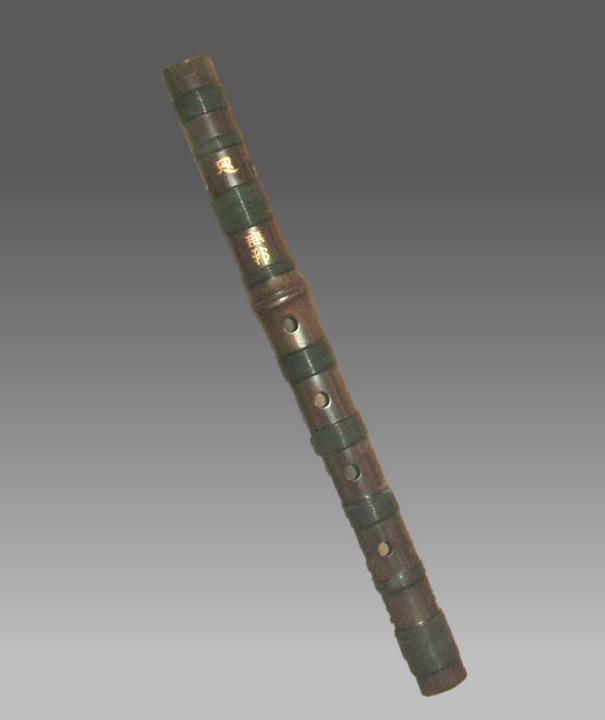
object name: hitoyogiri 一節切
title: Hitoyogiri (一節切)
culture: japanese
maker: attributed to ōmori sōkun 大森宗勲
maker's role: artist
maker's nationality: japanese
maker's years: 1570-1625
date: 1567-1633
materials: bamboo, gilt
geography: japan